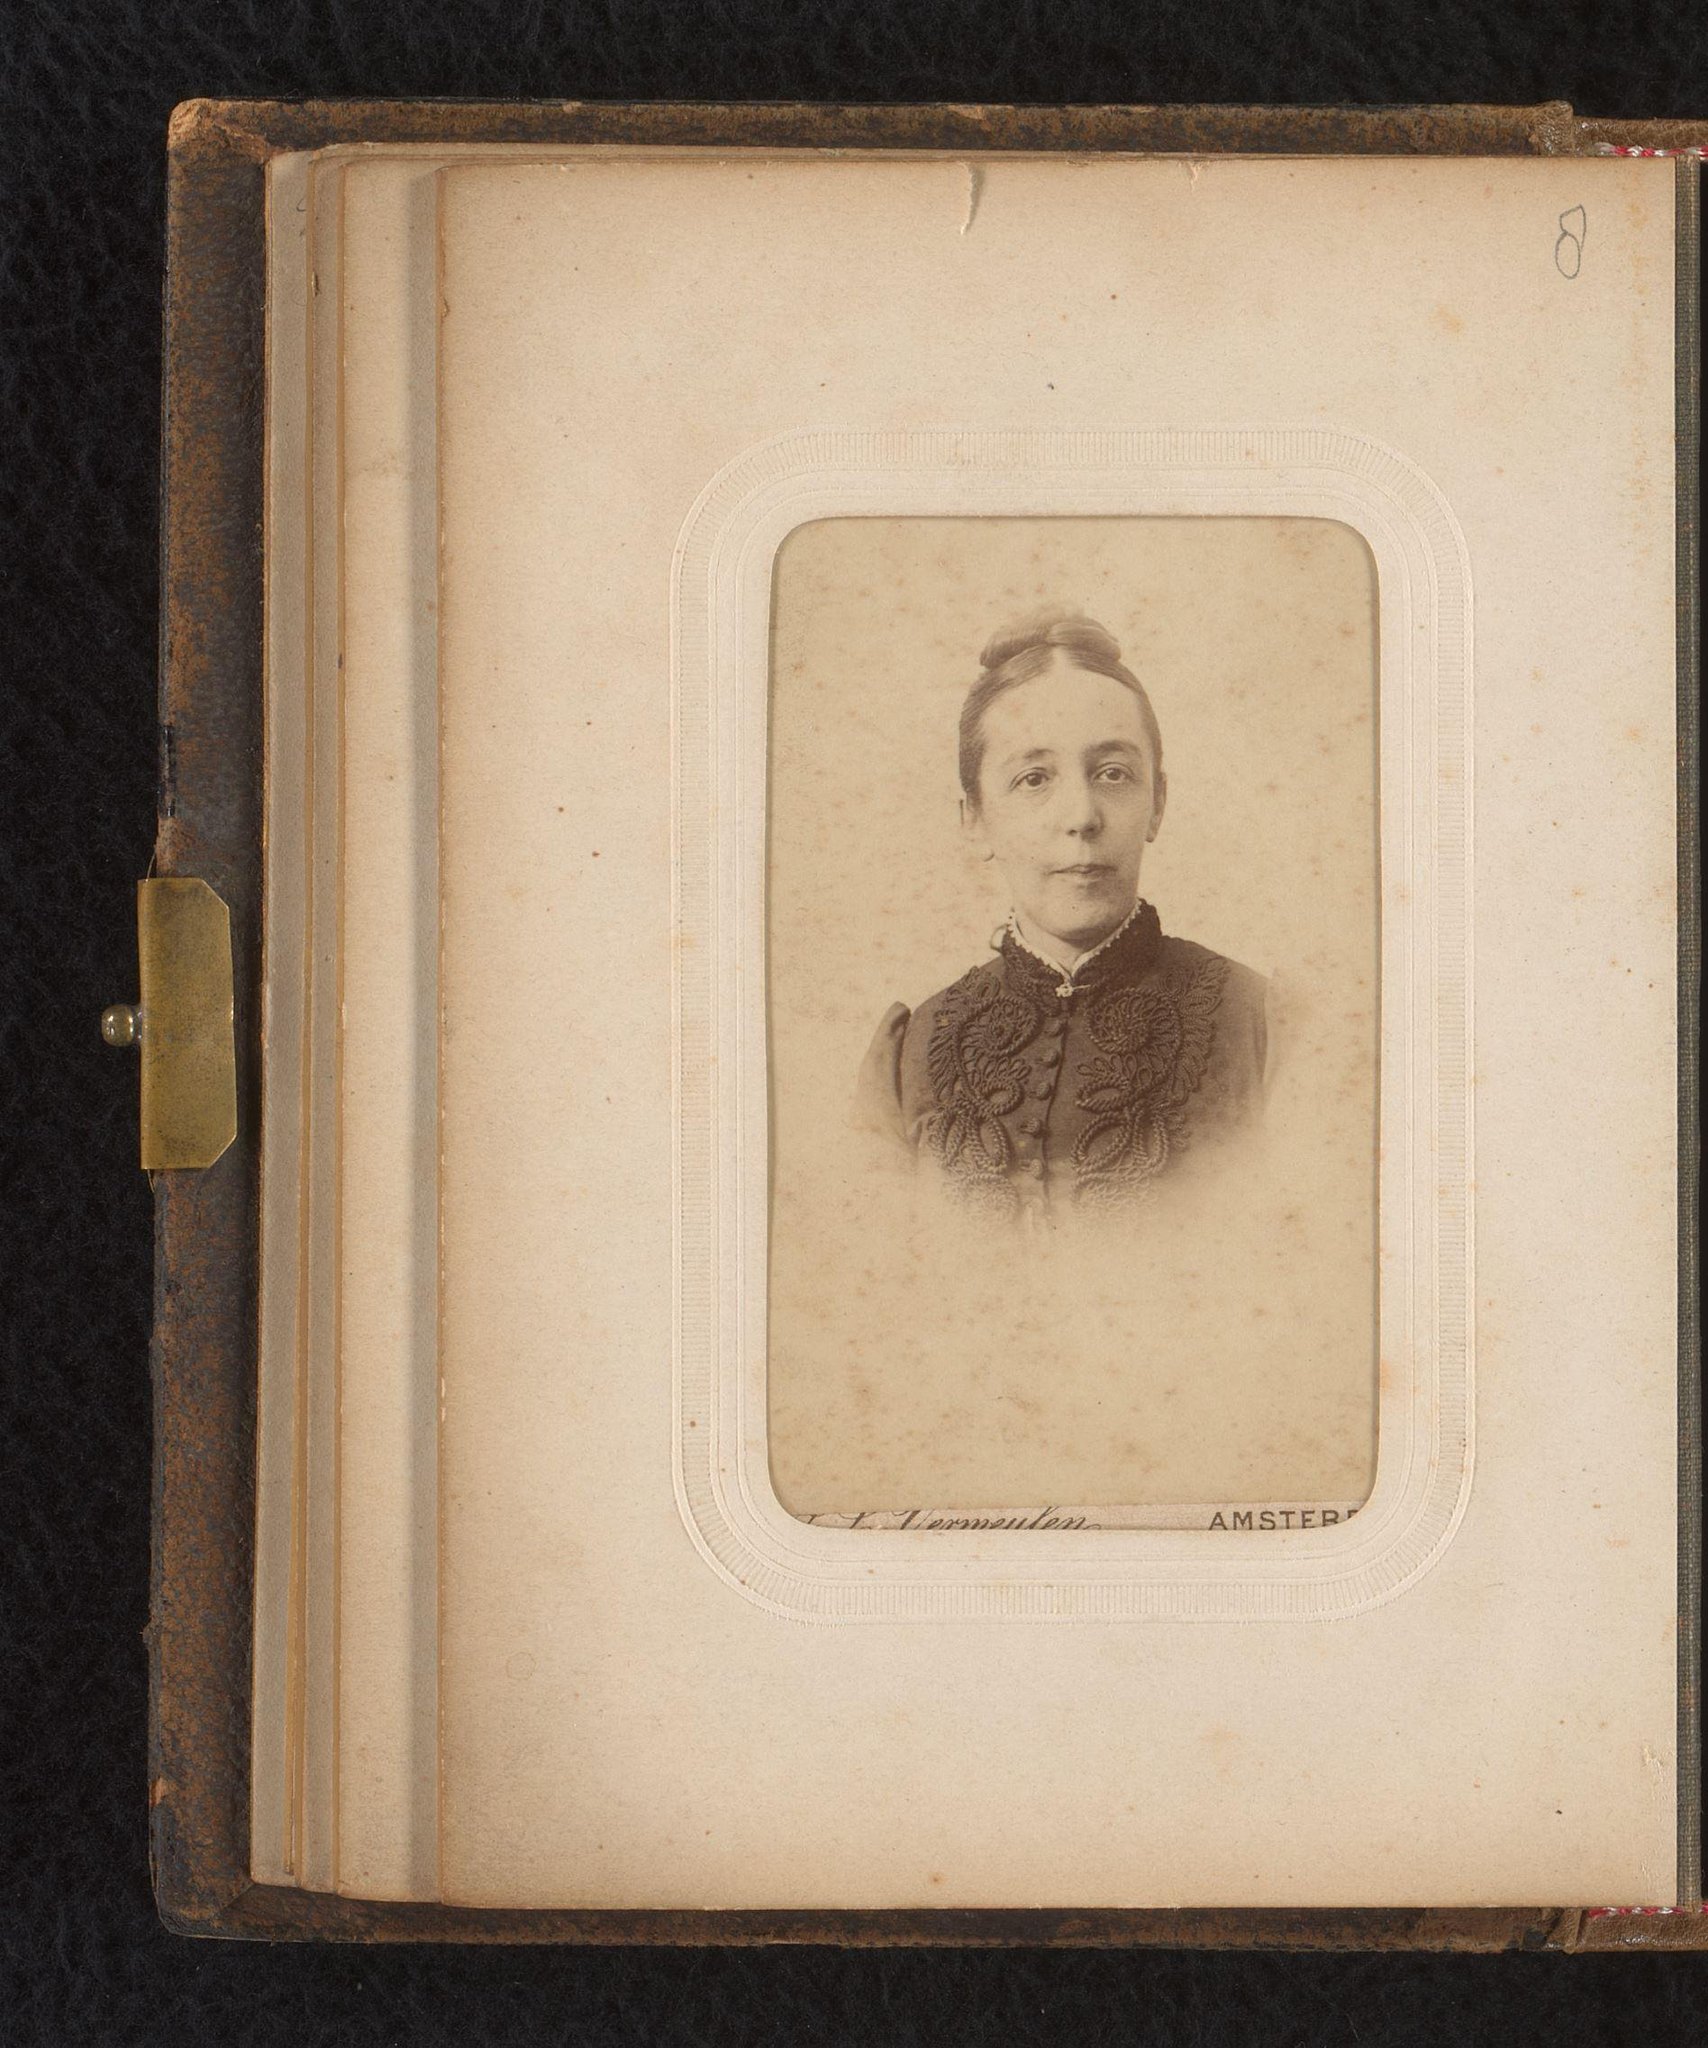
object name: carte de visite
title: Portret van Sijtje van Leijden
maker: cornelis johannes lodewicus vermeulen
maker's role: fotograaf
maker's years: 1861-1936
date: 1888-1896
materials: cardboard, paper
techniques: albumen print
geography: amsterdam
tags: historical persons - bb - woman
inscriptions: inscription: ‘Tante Sytje?/ zuster van grootmoeder/ Bon-v. Leyden’, inscription: ‘Photographische/ Ateliers/ C.J.L. Vermeulen/ Heerenstraat 6/ &/ Heiligenweg/ hoek Singel’, inscription: ‘C.J.L. Vermeulen Amsterdam’